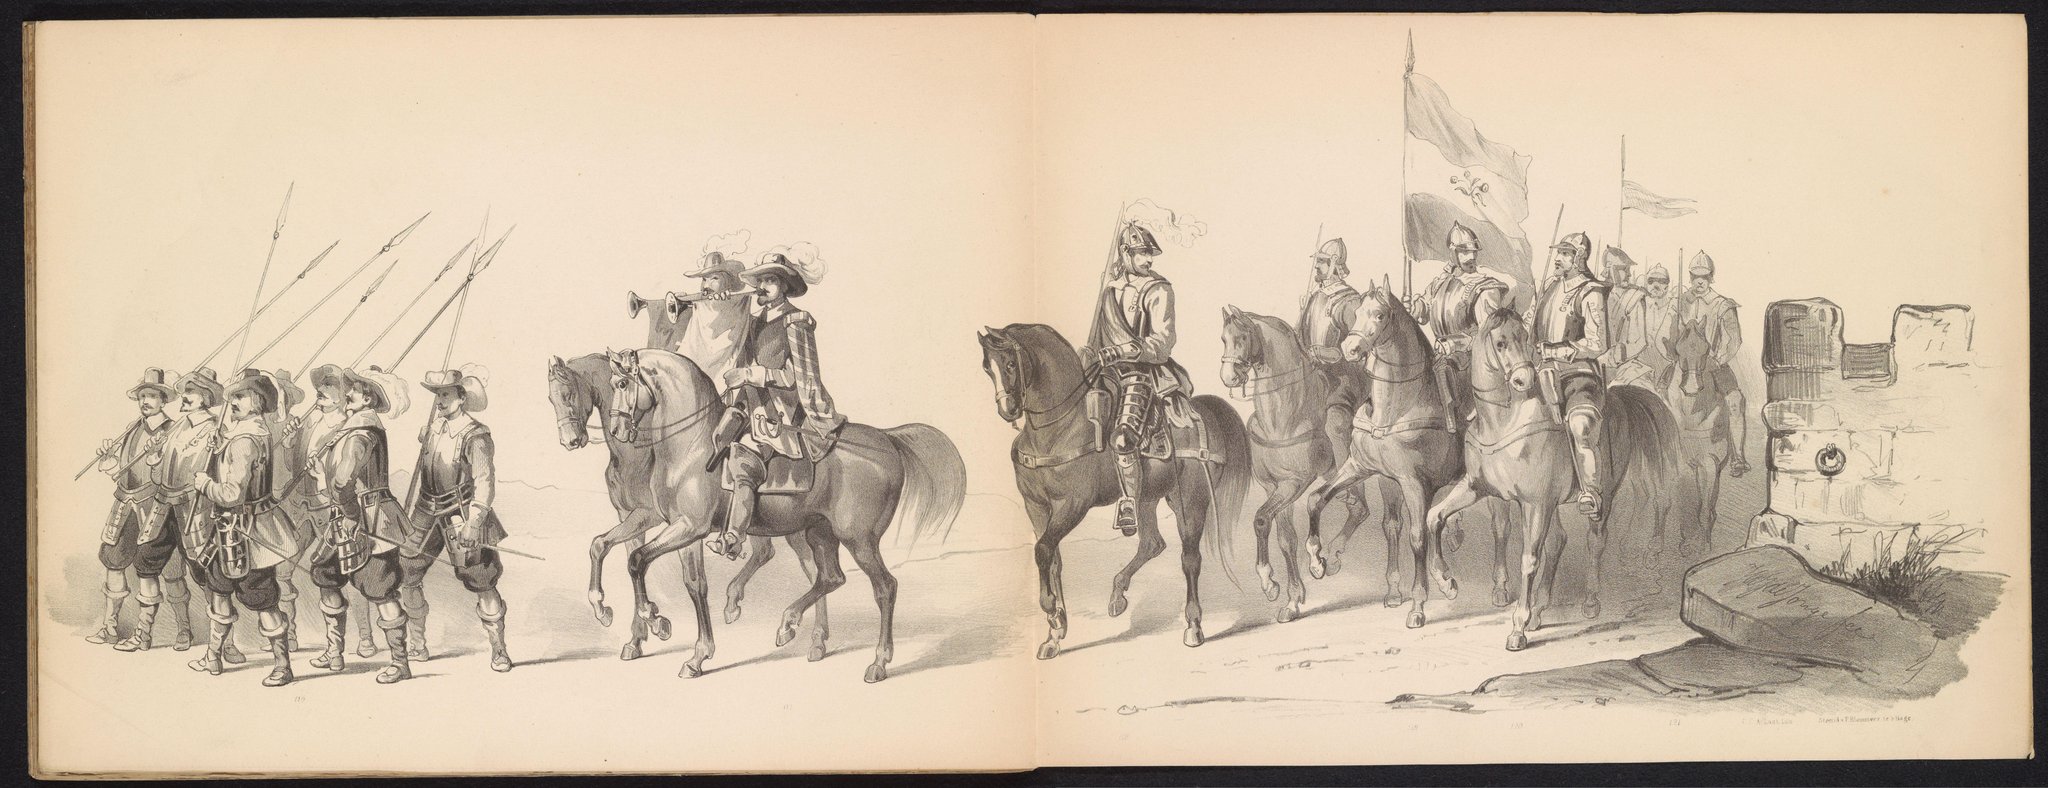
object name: text sheet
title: Intogt van Frederik Hendrik in 's Hertogenbosch in 1629 : gecostumeerde voorstelling door de H.H. studenten der Leydsche Hoogeschool den XI Junij van het jaar 1850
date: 1850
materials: paper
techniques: lithograph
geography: the hague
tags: delft, frederick henry (prince of orange), students' pageant, costumes used in pageants, leiden, den bosch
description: Historische gekostumeerde optocht van de studenten van de Leidse Hogeschool op 11 juni 1850. De optocht verbeeldt de intocht van Frederik Hendrik te Den Bosch in 1629. Dertiende plaat met de groepen genummerd 109-115. Onderdeel van de serie van dertien aanelkaar geplakte bladen.